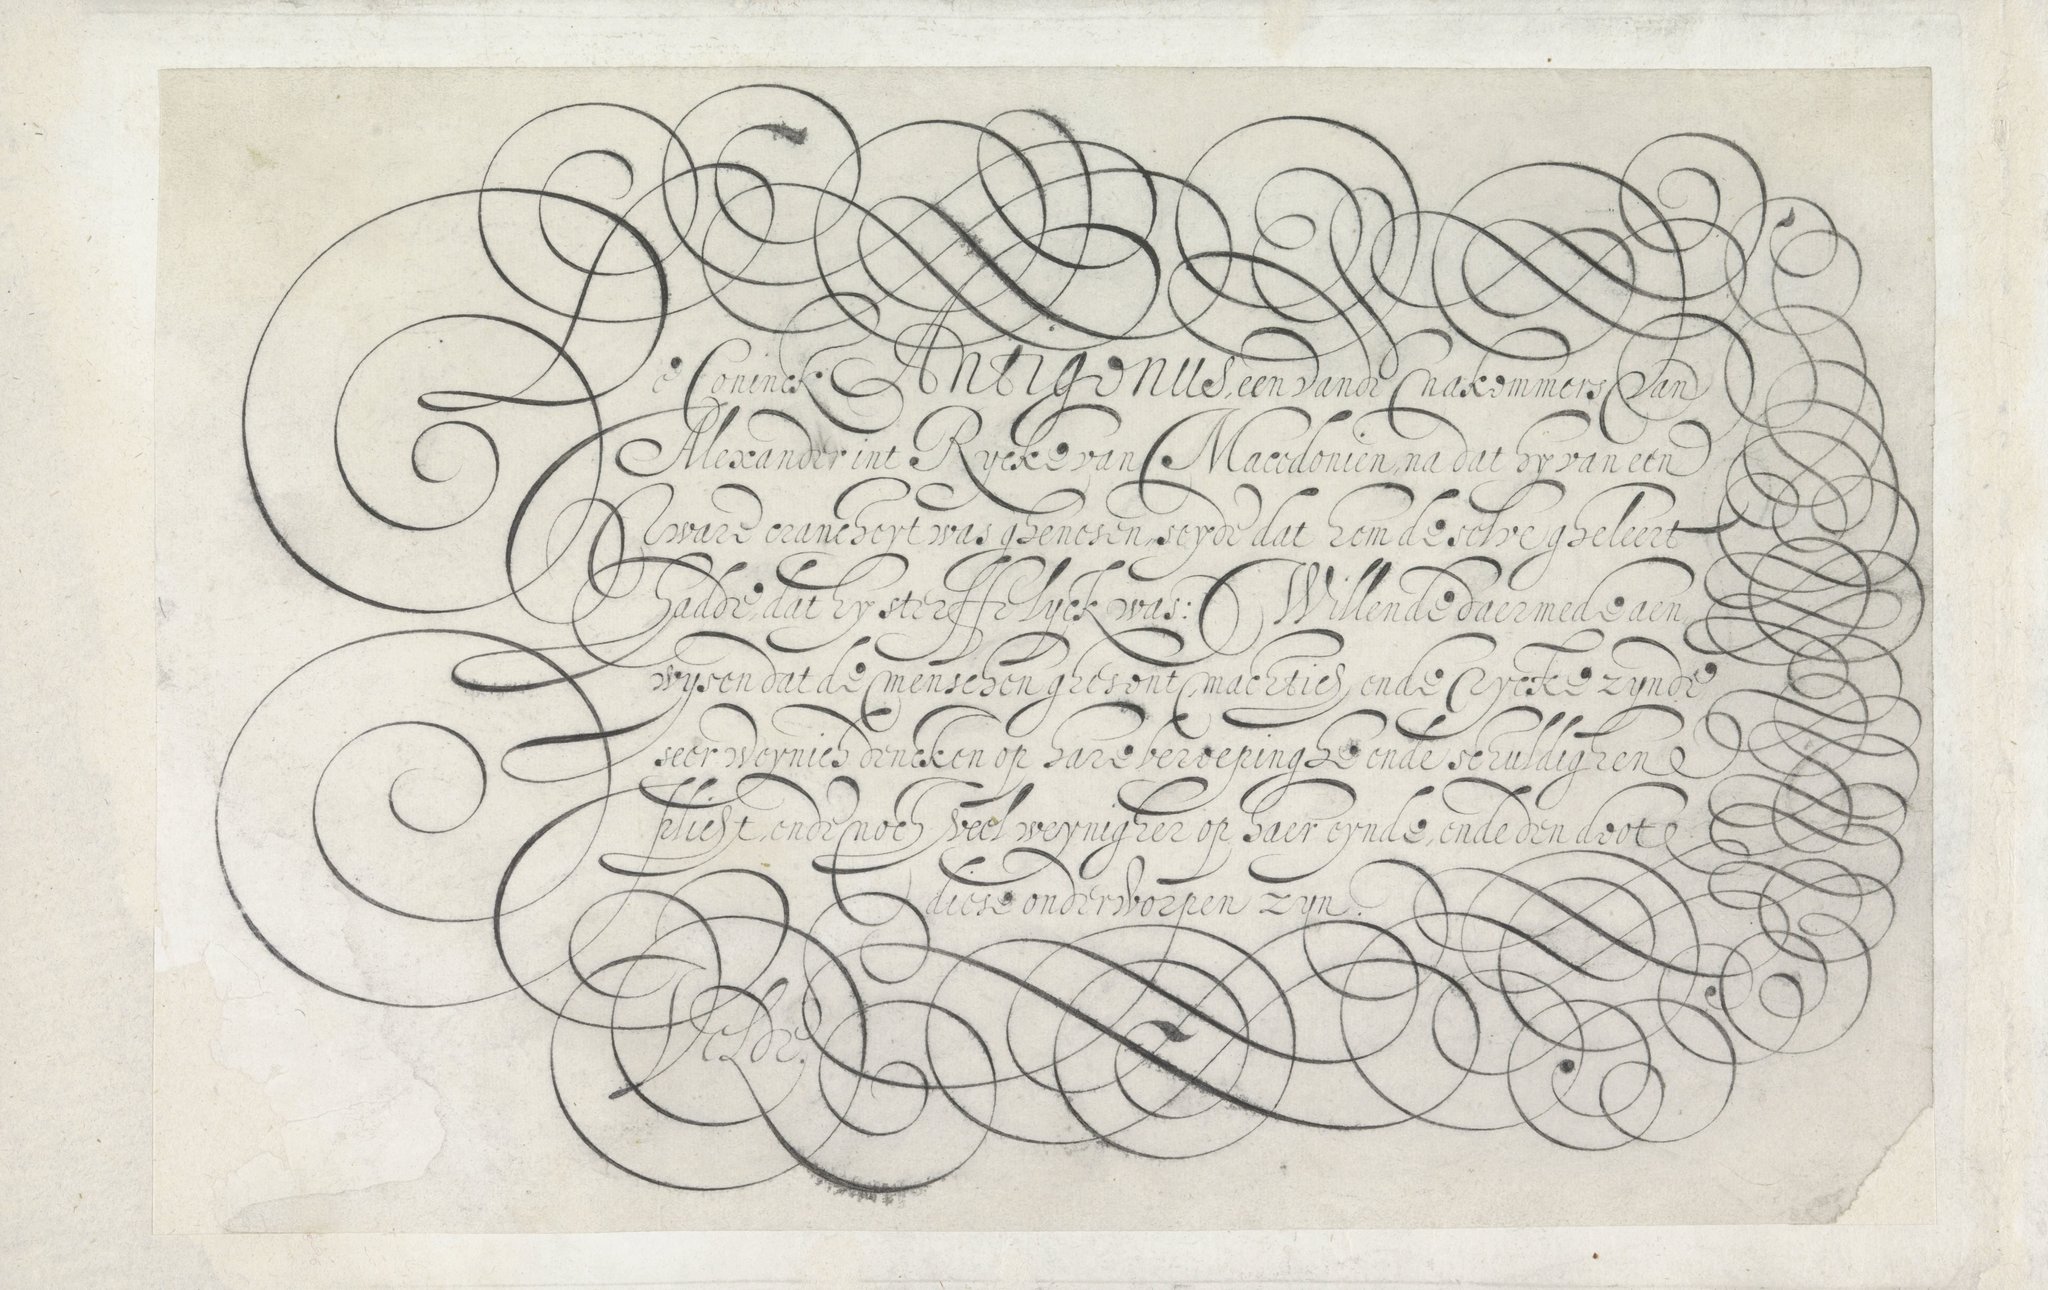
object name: album leaf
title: Spieghel der schrijfkonste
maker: jan van de velde (i)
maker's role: painter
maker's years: 1568-1623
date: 1605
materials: ink, paper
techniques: calligraphy, pen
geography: rotterdam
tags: calligraphy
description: Kalligrafische tekening met acht regels tekst in het Nederlands: De coninck Antigonus ... De tekst is omlijst met krulwerk. De tekening maakt deel uit van een album.